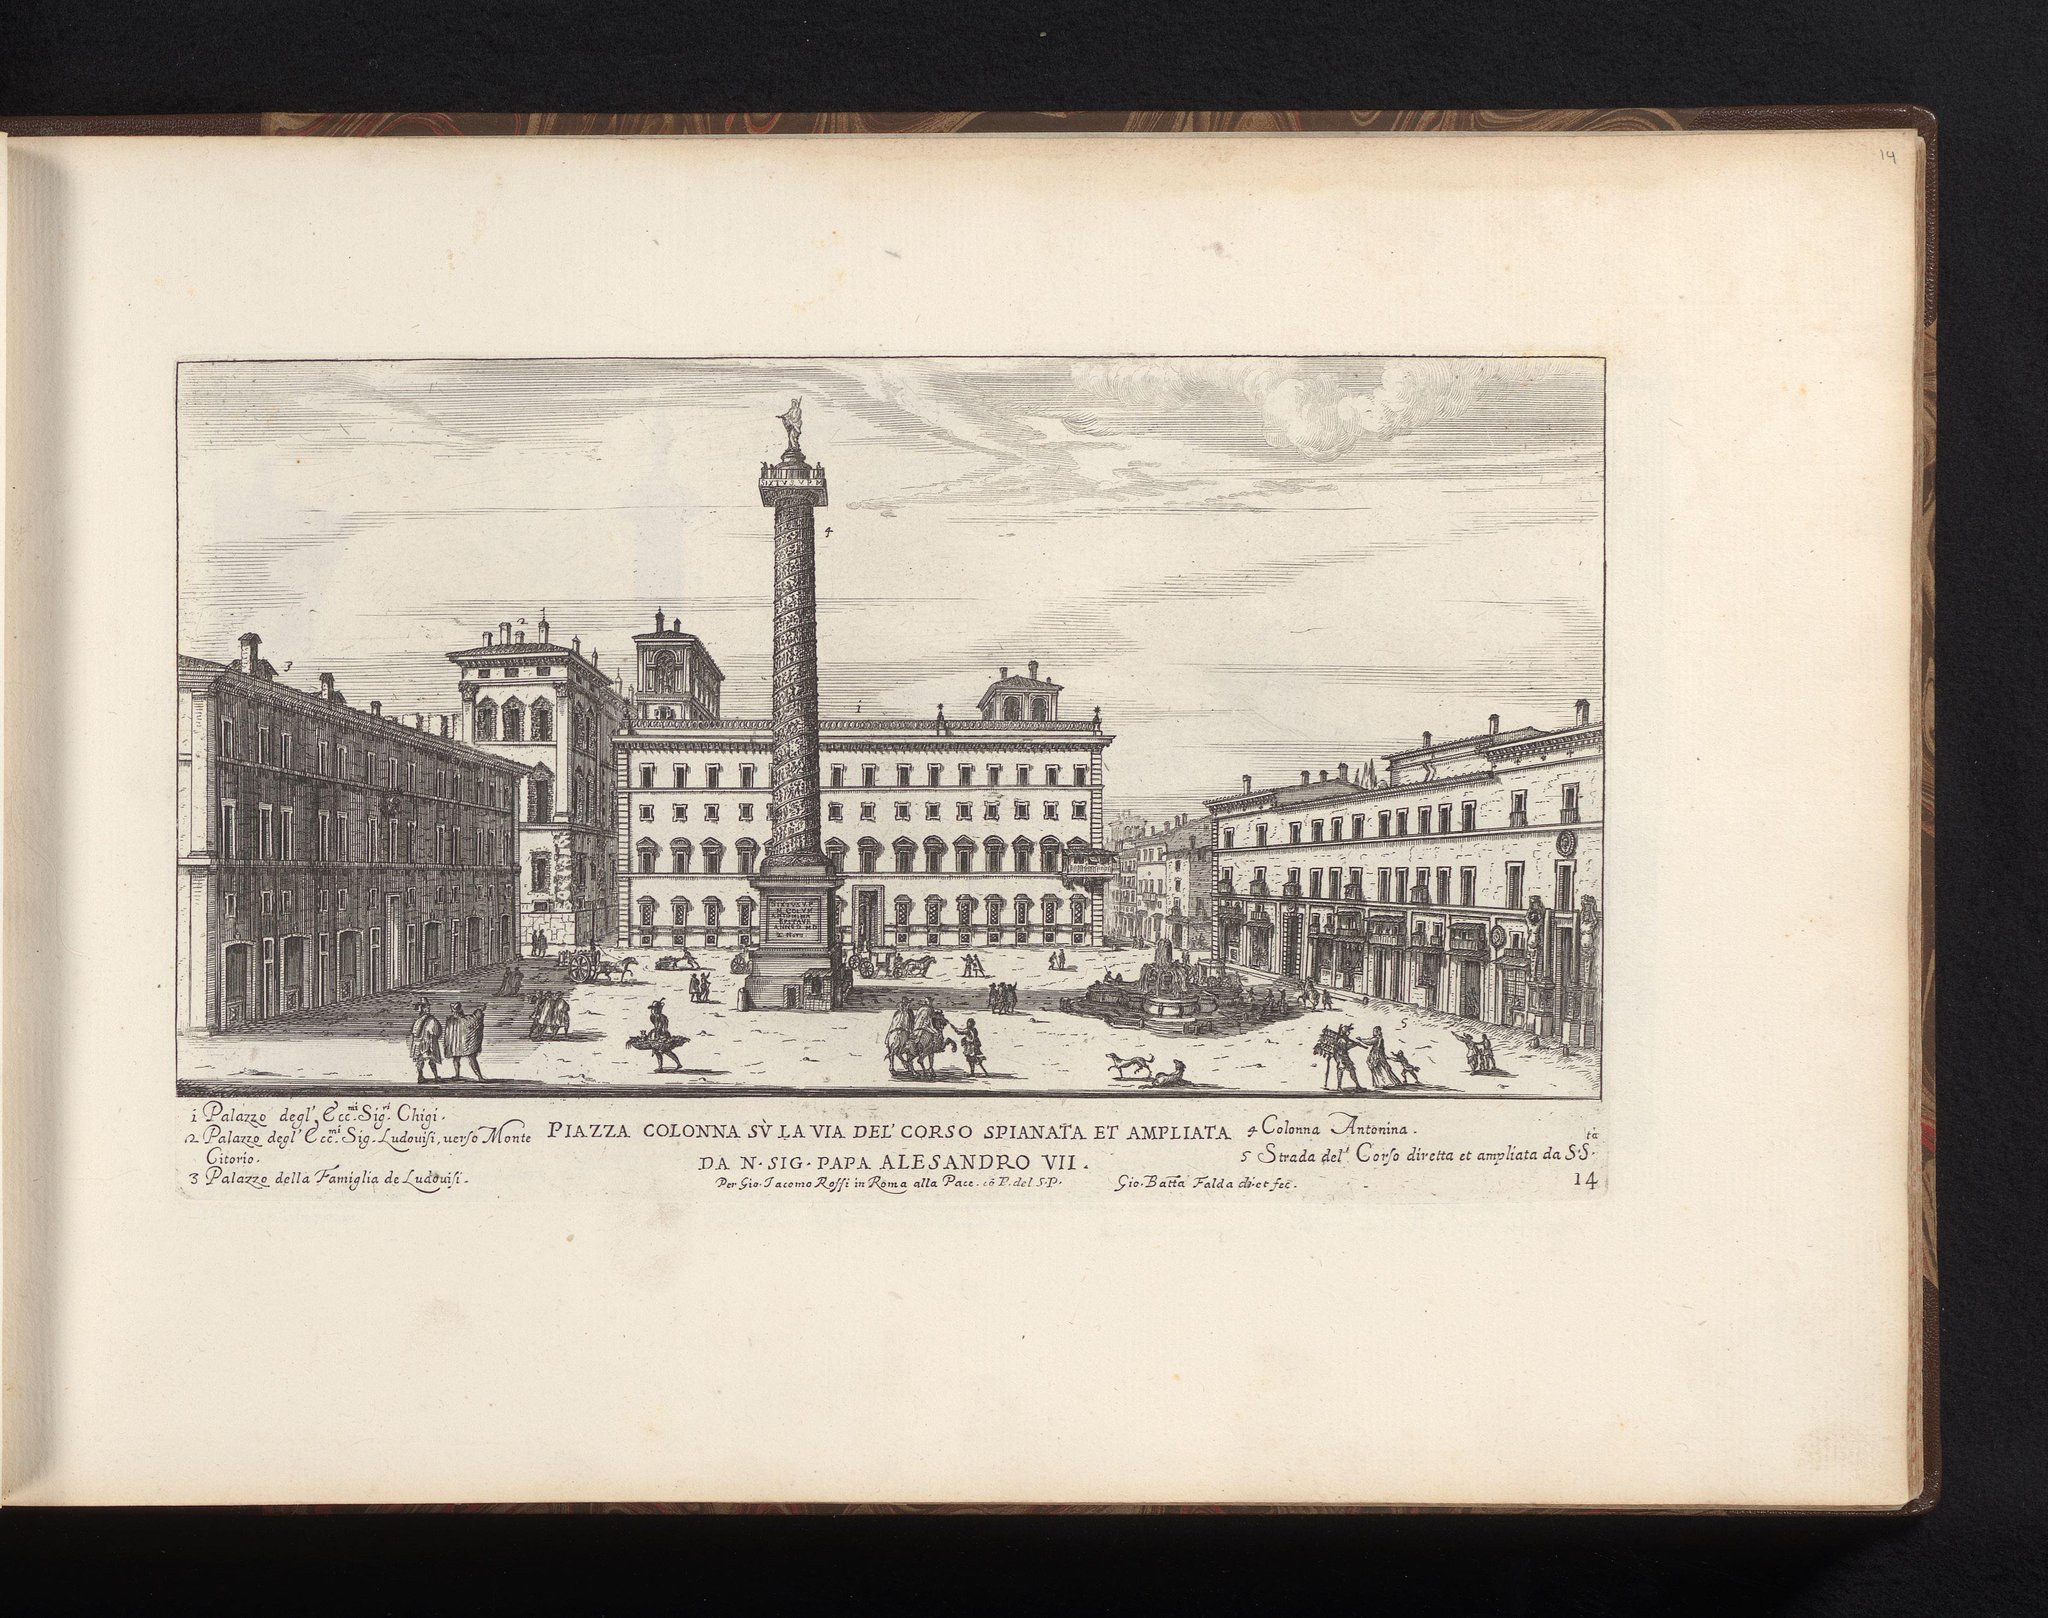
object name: print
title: Il nuovo teatro delle fabriche, et edificii, in prospettiva di Rome Modern (...) (libro primo)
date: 1665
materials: paper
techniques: etching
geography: italy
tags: square, place, circus, etc., city-view, and landscape with man-made constructions, triumphal column with helical friezes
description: Deze prent maakt deel uit van een reeks van 35 prenten met voorstellingen van gebouwen in Rome. Samen met vier andere reeksen vormt het de grote reeks: 'Il nuovo teatro di Roma moderna'.